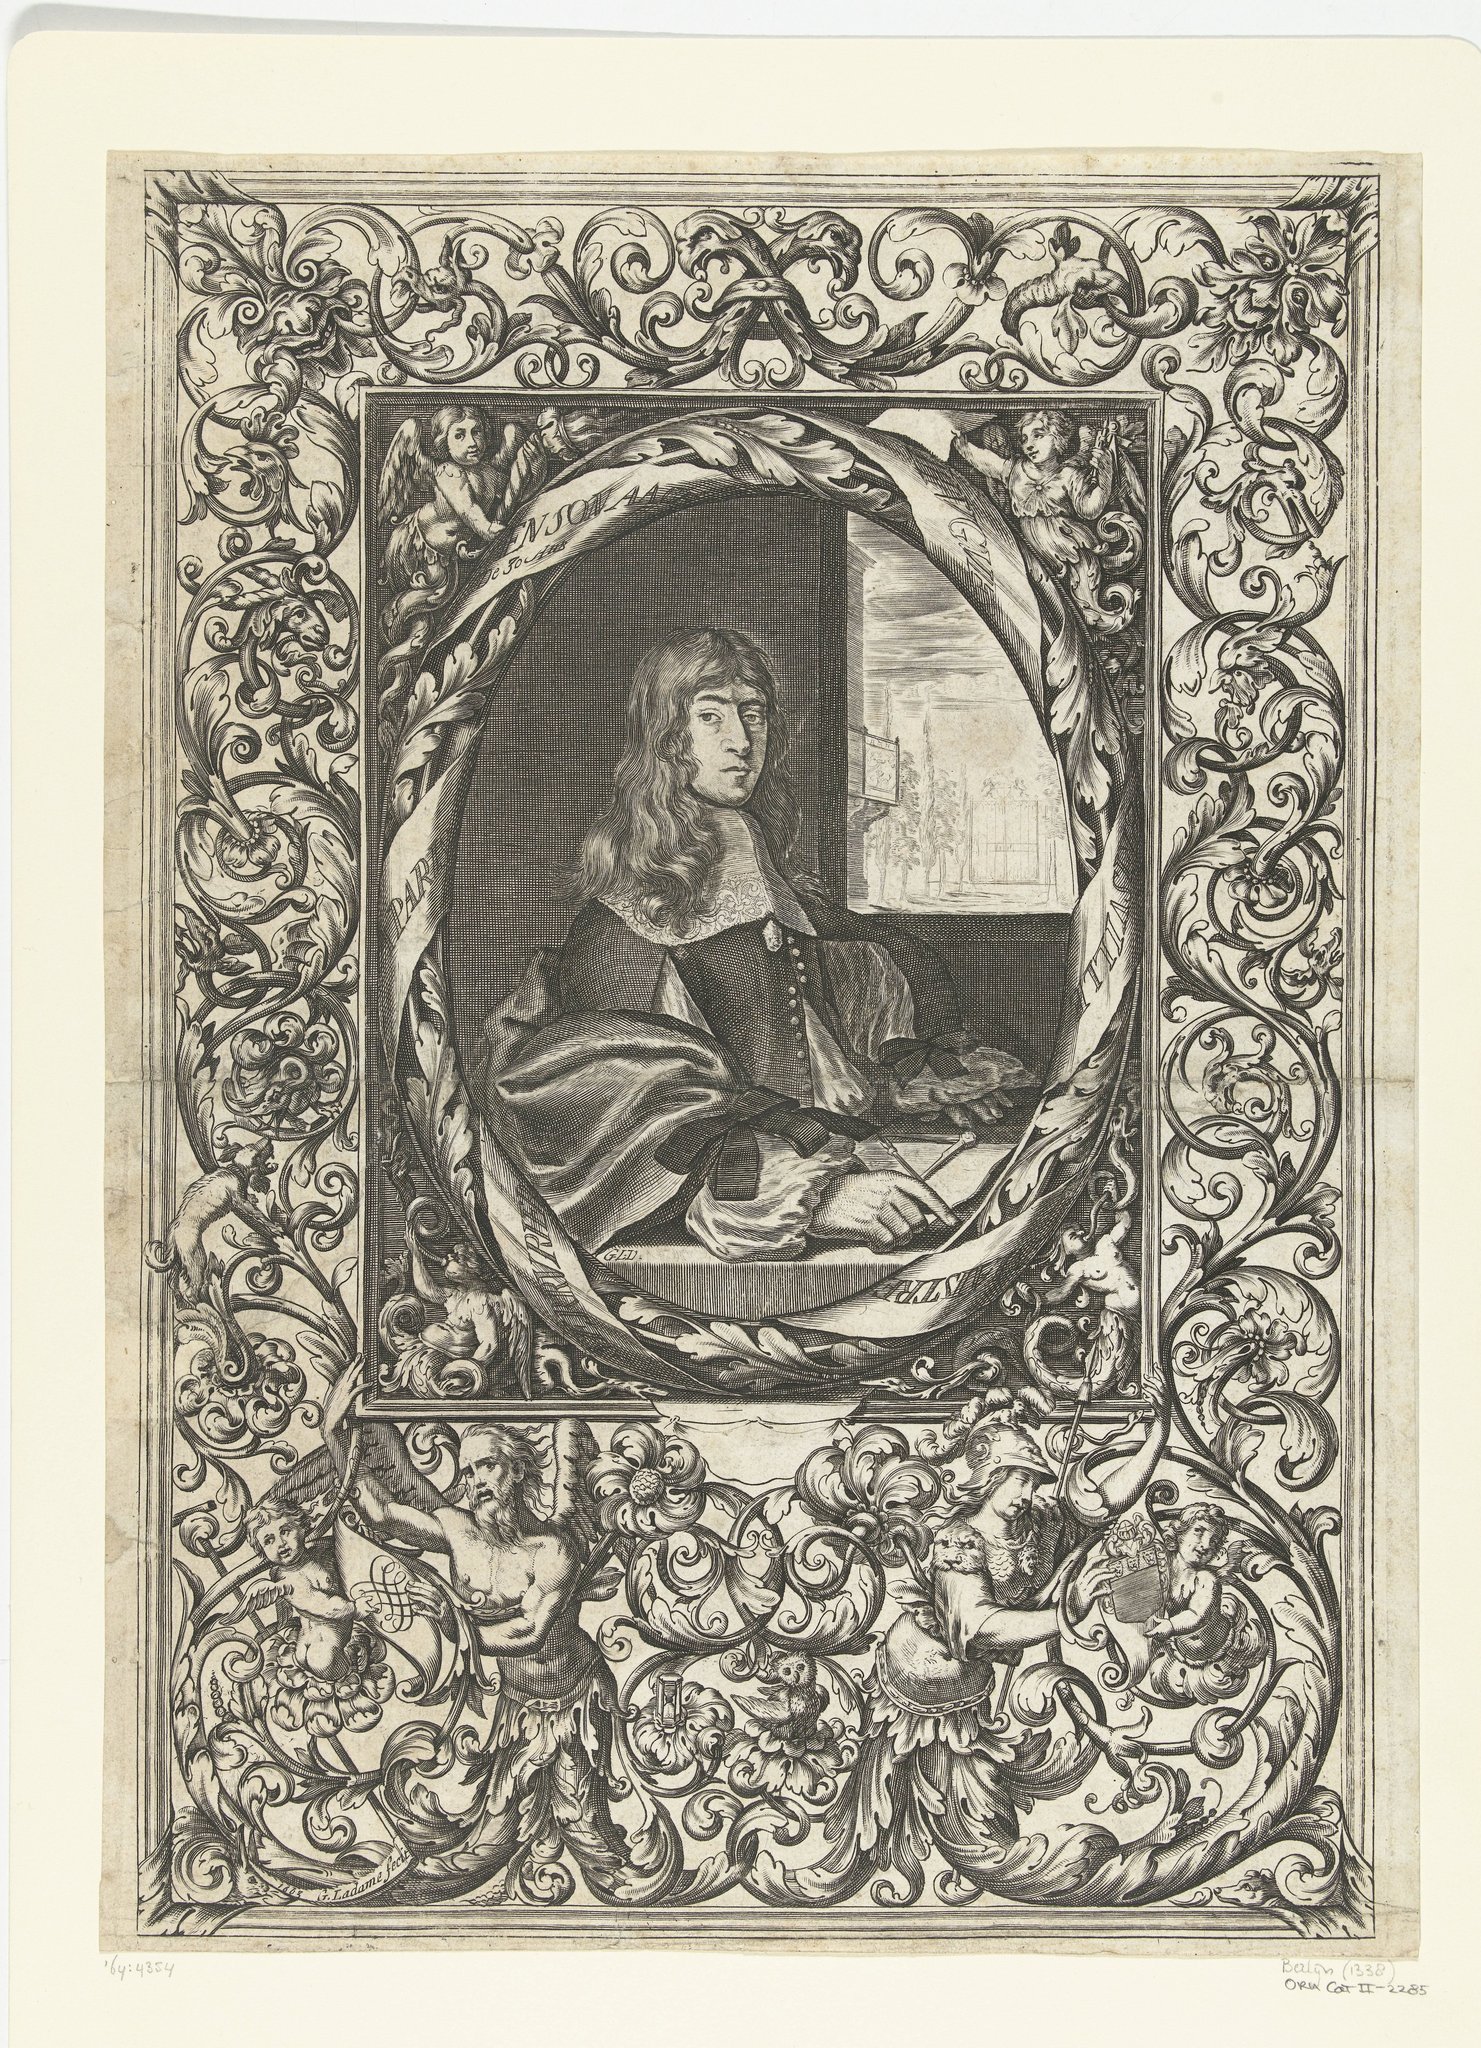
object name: ornament print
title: Hvgue Brisville maistre serrurier a Paris en son aage De 30 Ans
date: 1663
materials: paper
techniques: engraving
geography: paris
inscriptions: date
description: Portret in ovaal, driekwart naar rechts, zittend aan tafel met een stuk papier, een krijthouder en een kompas. Het ovaal bevindt zich in een rechthoekige lijst met in vier hoeken een putto. Het geheel is omlijst met bladranken met dieren en maskers waaruit twee figuren ontspringen, namelijk Tijd en Minerva.